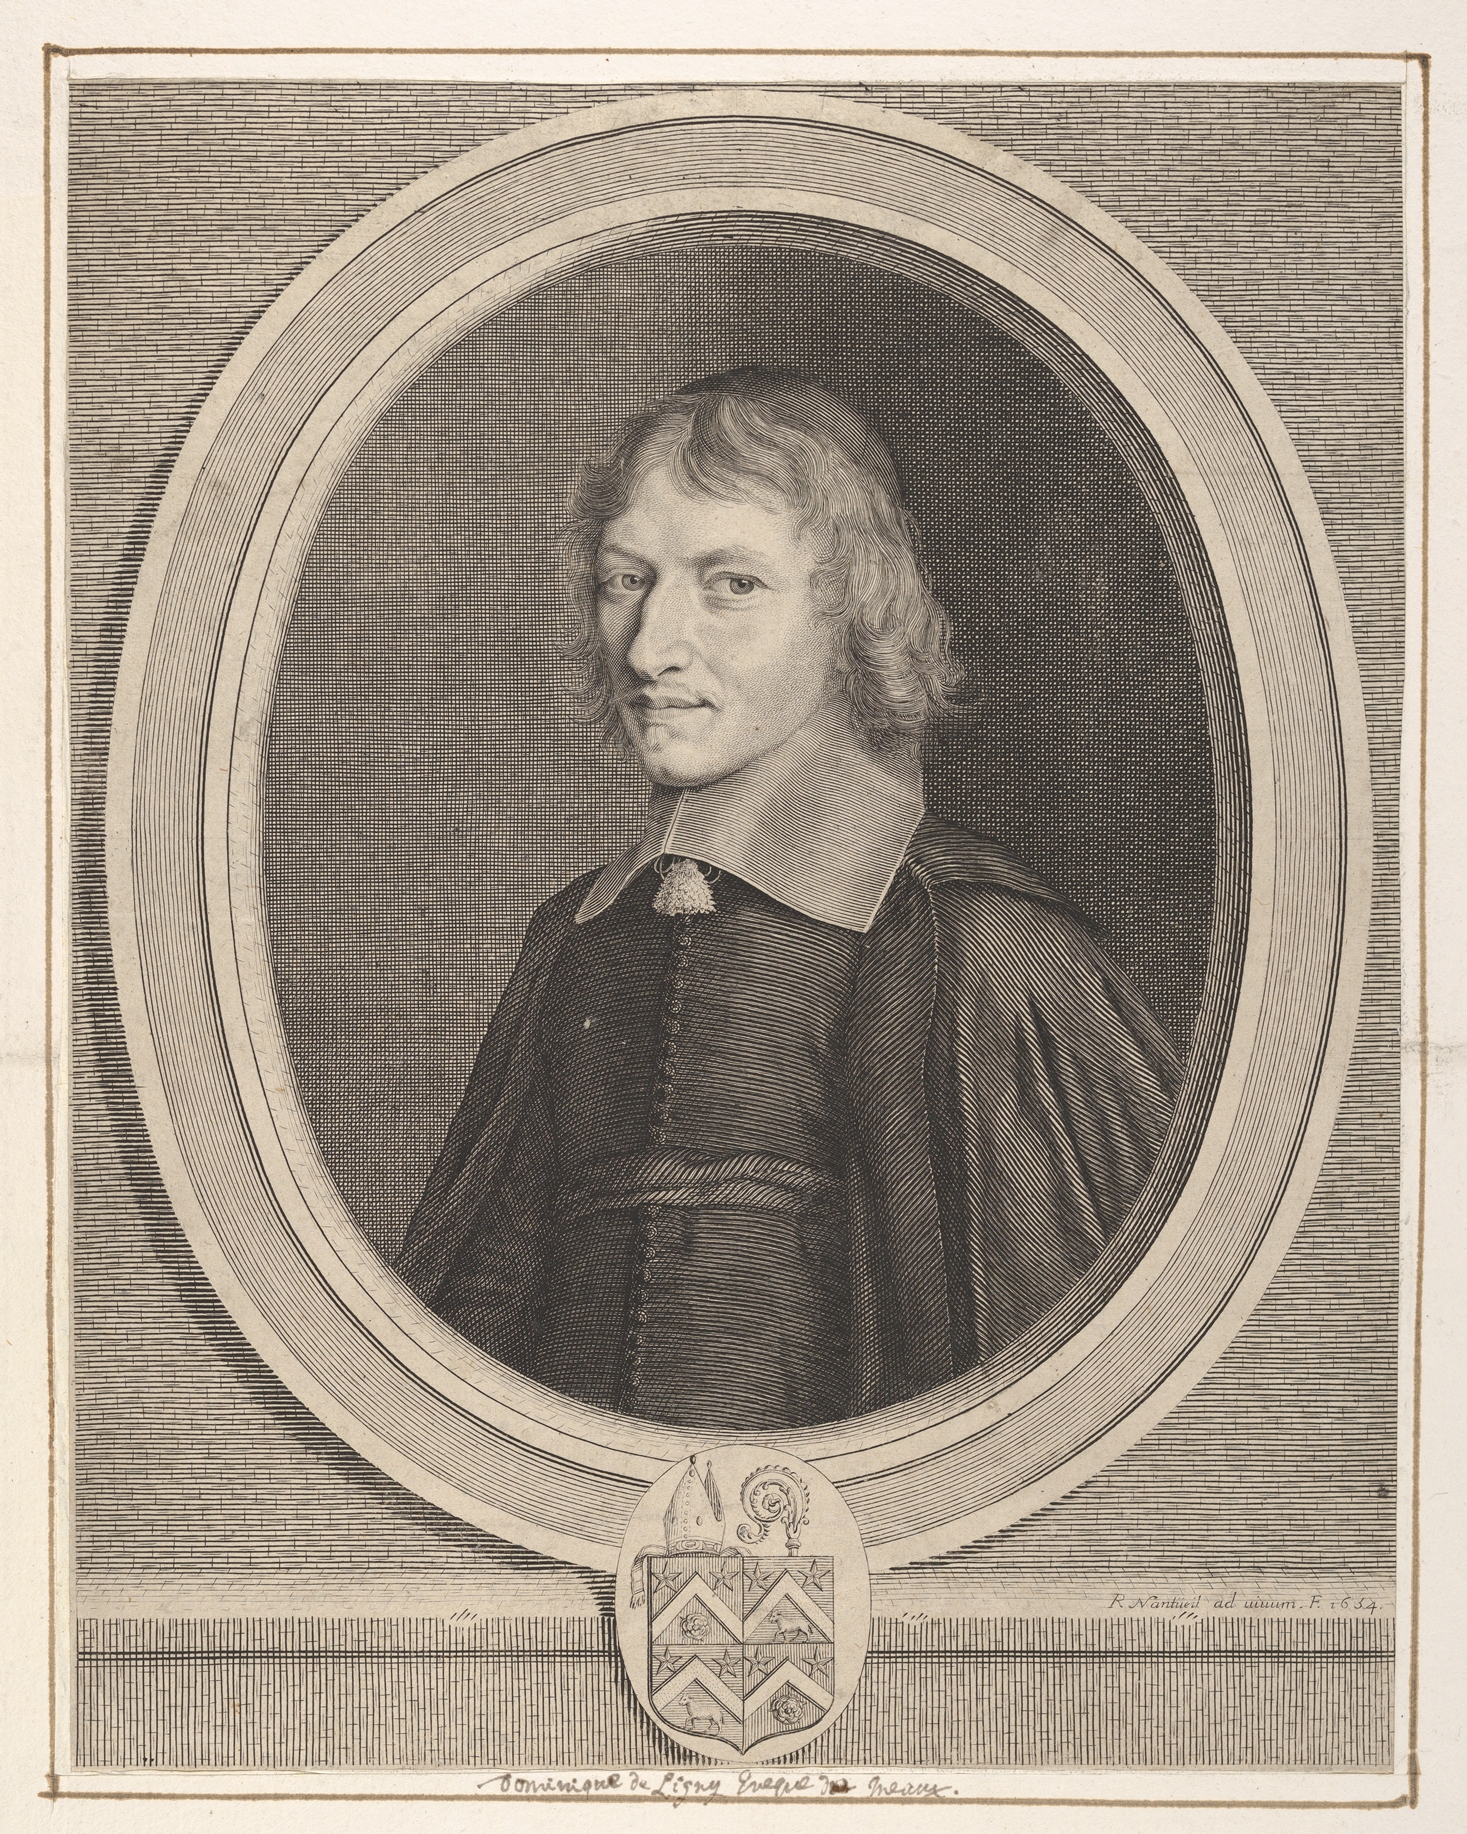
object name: print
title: Dominique de Ligny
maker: robert nanteuil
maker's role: artist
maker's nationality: french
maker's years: 1623-1678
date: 1654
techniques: engraving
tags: men,portraits